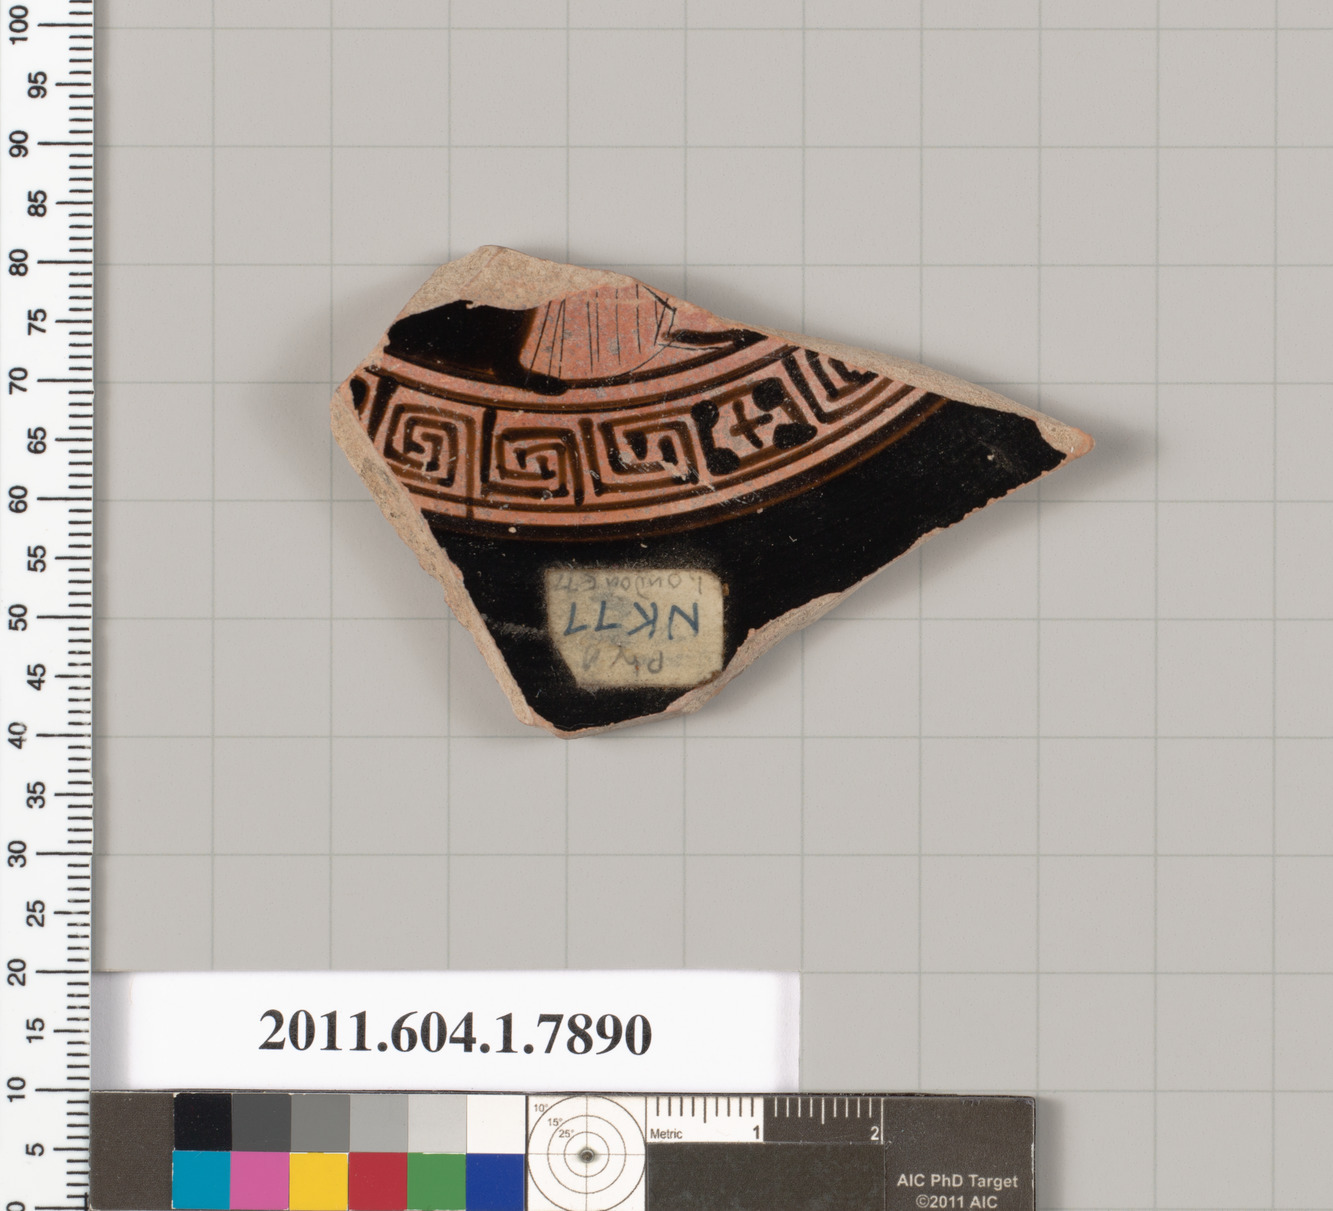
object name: kylix fragment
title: Terracotta fragment of a kylix (drinking cup)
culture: greek, attic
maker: painter of london e 777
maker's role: artist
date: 450 BCE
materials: terracotta